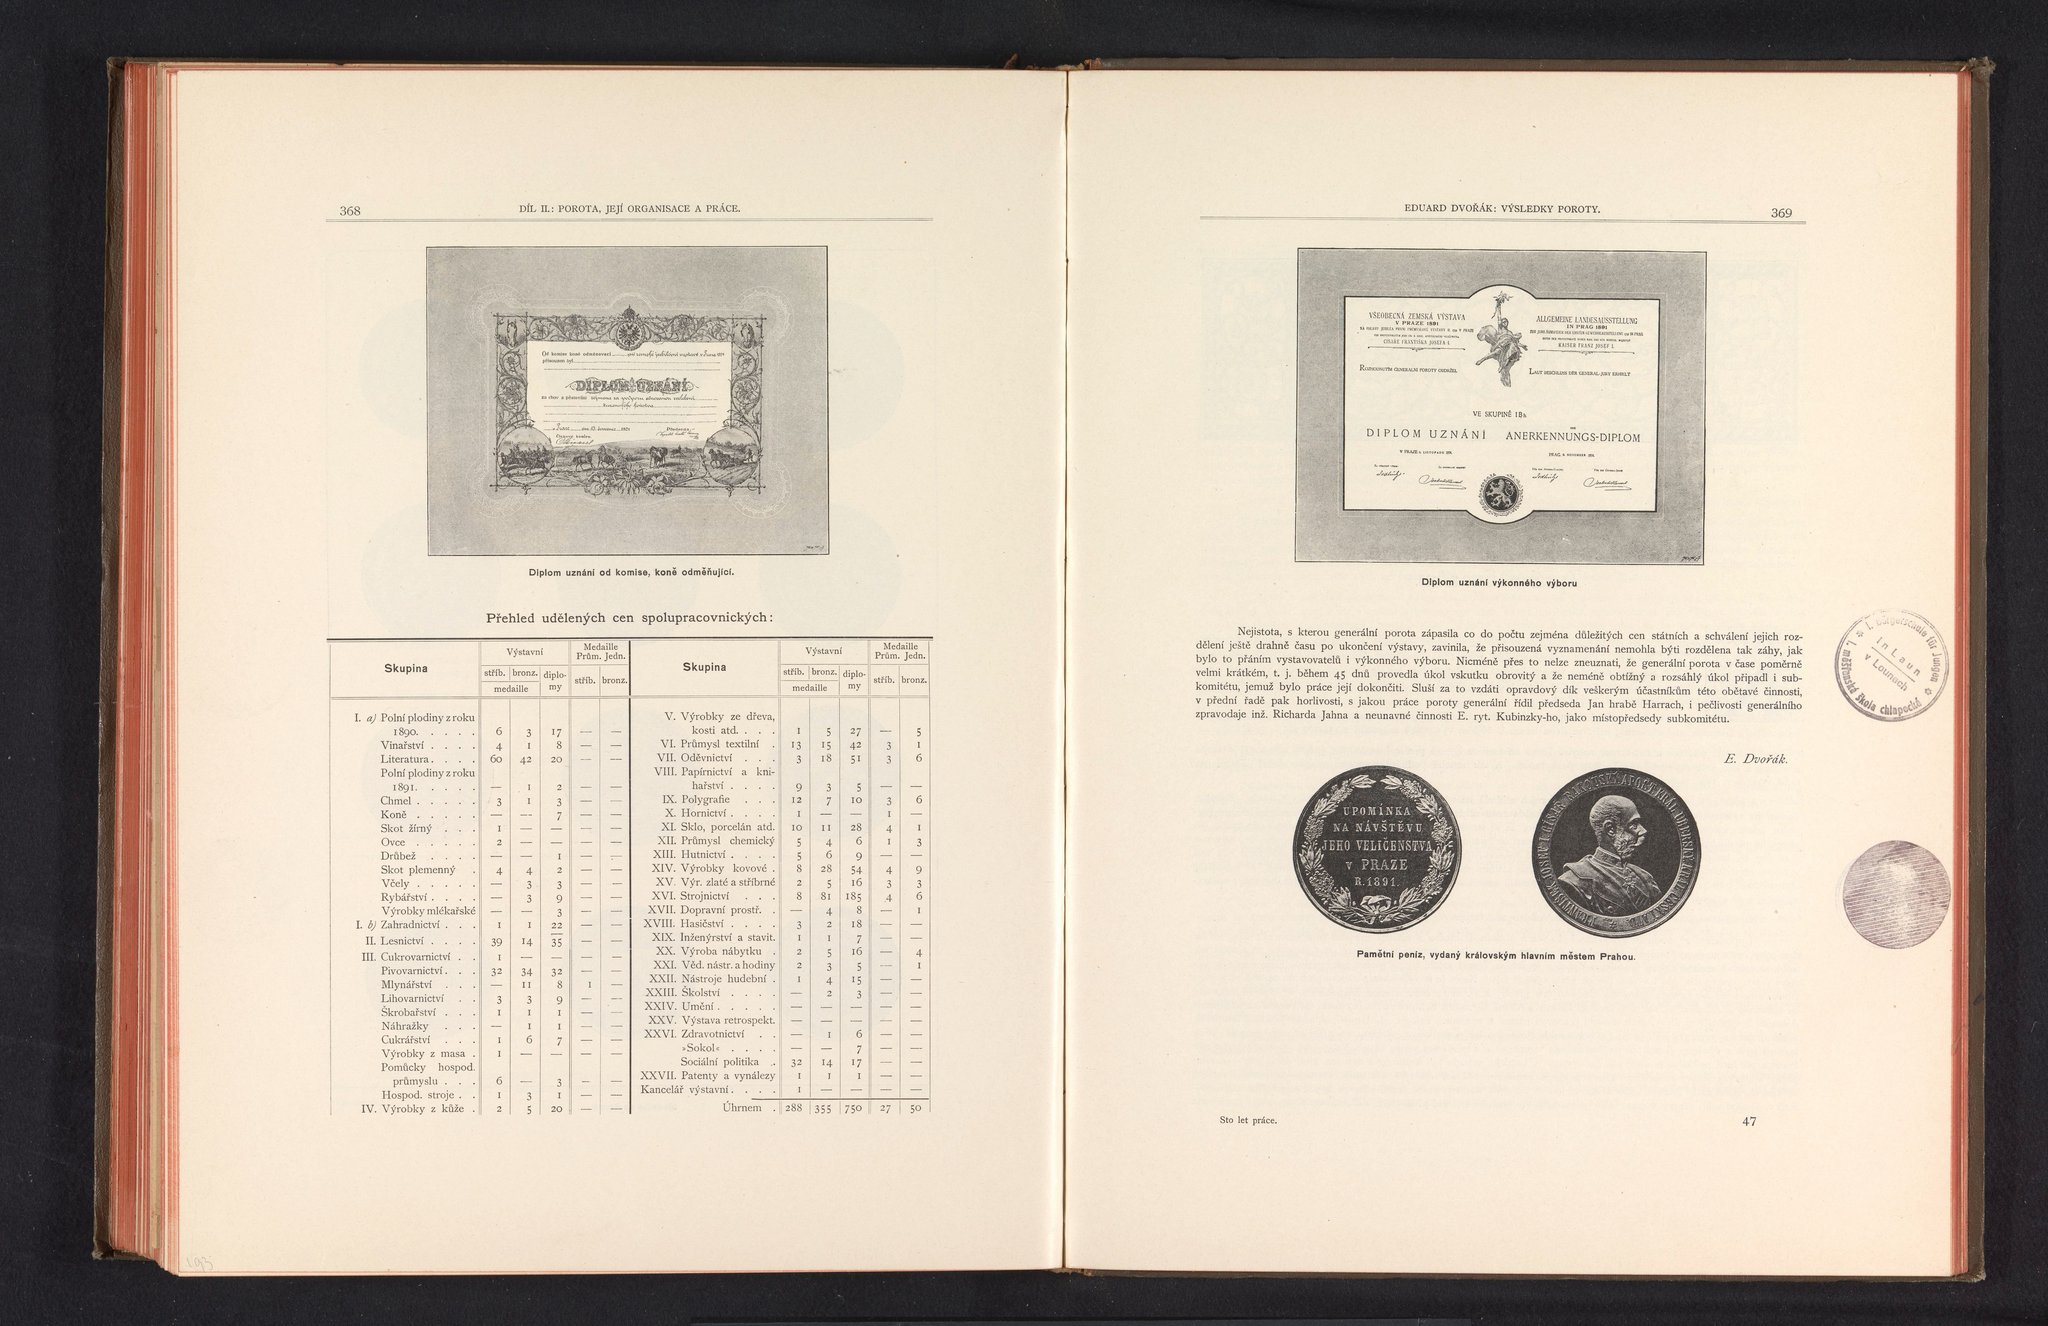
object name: page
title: Diploma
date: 1891-1893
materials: paper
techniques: autotype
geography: prague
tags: single printed leaf: broadsheet, leaflet